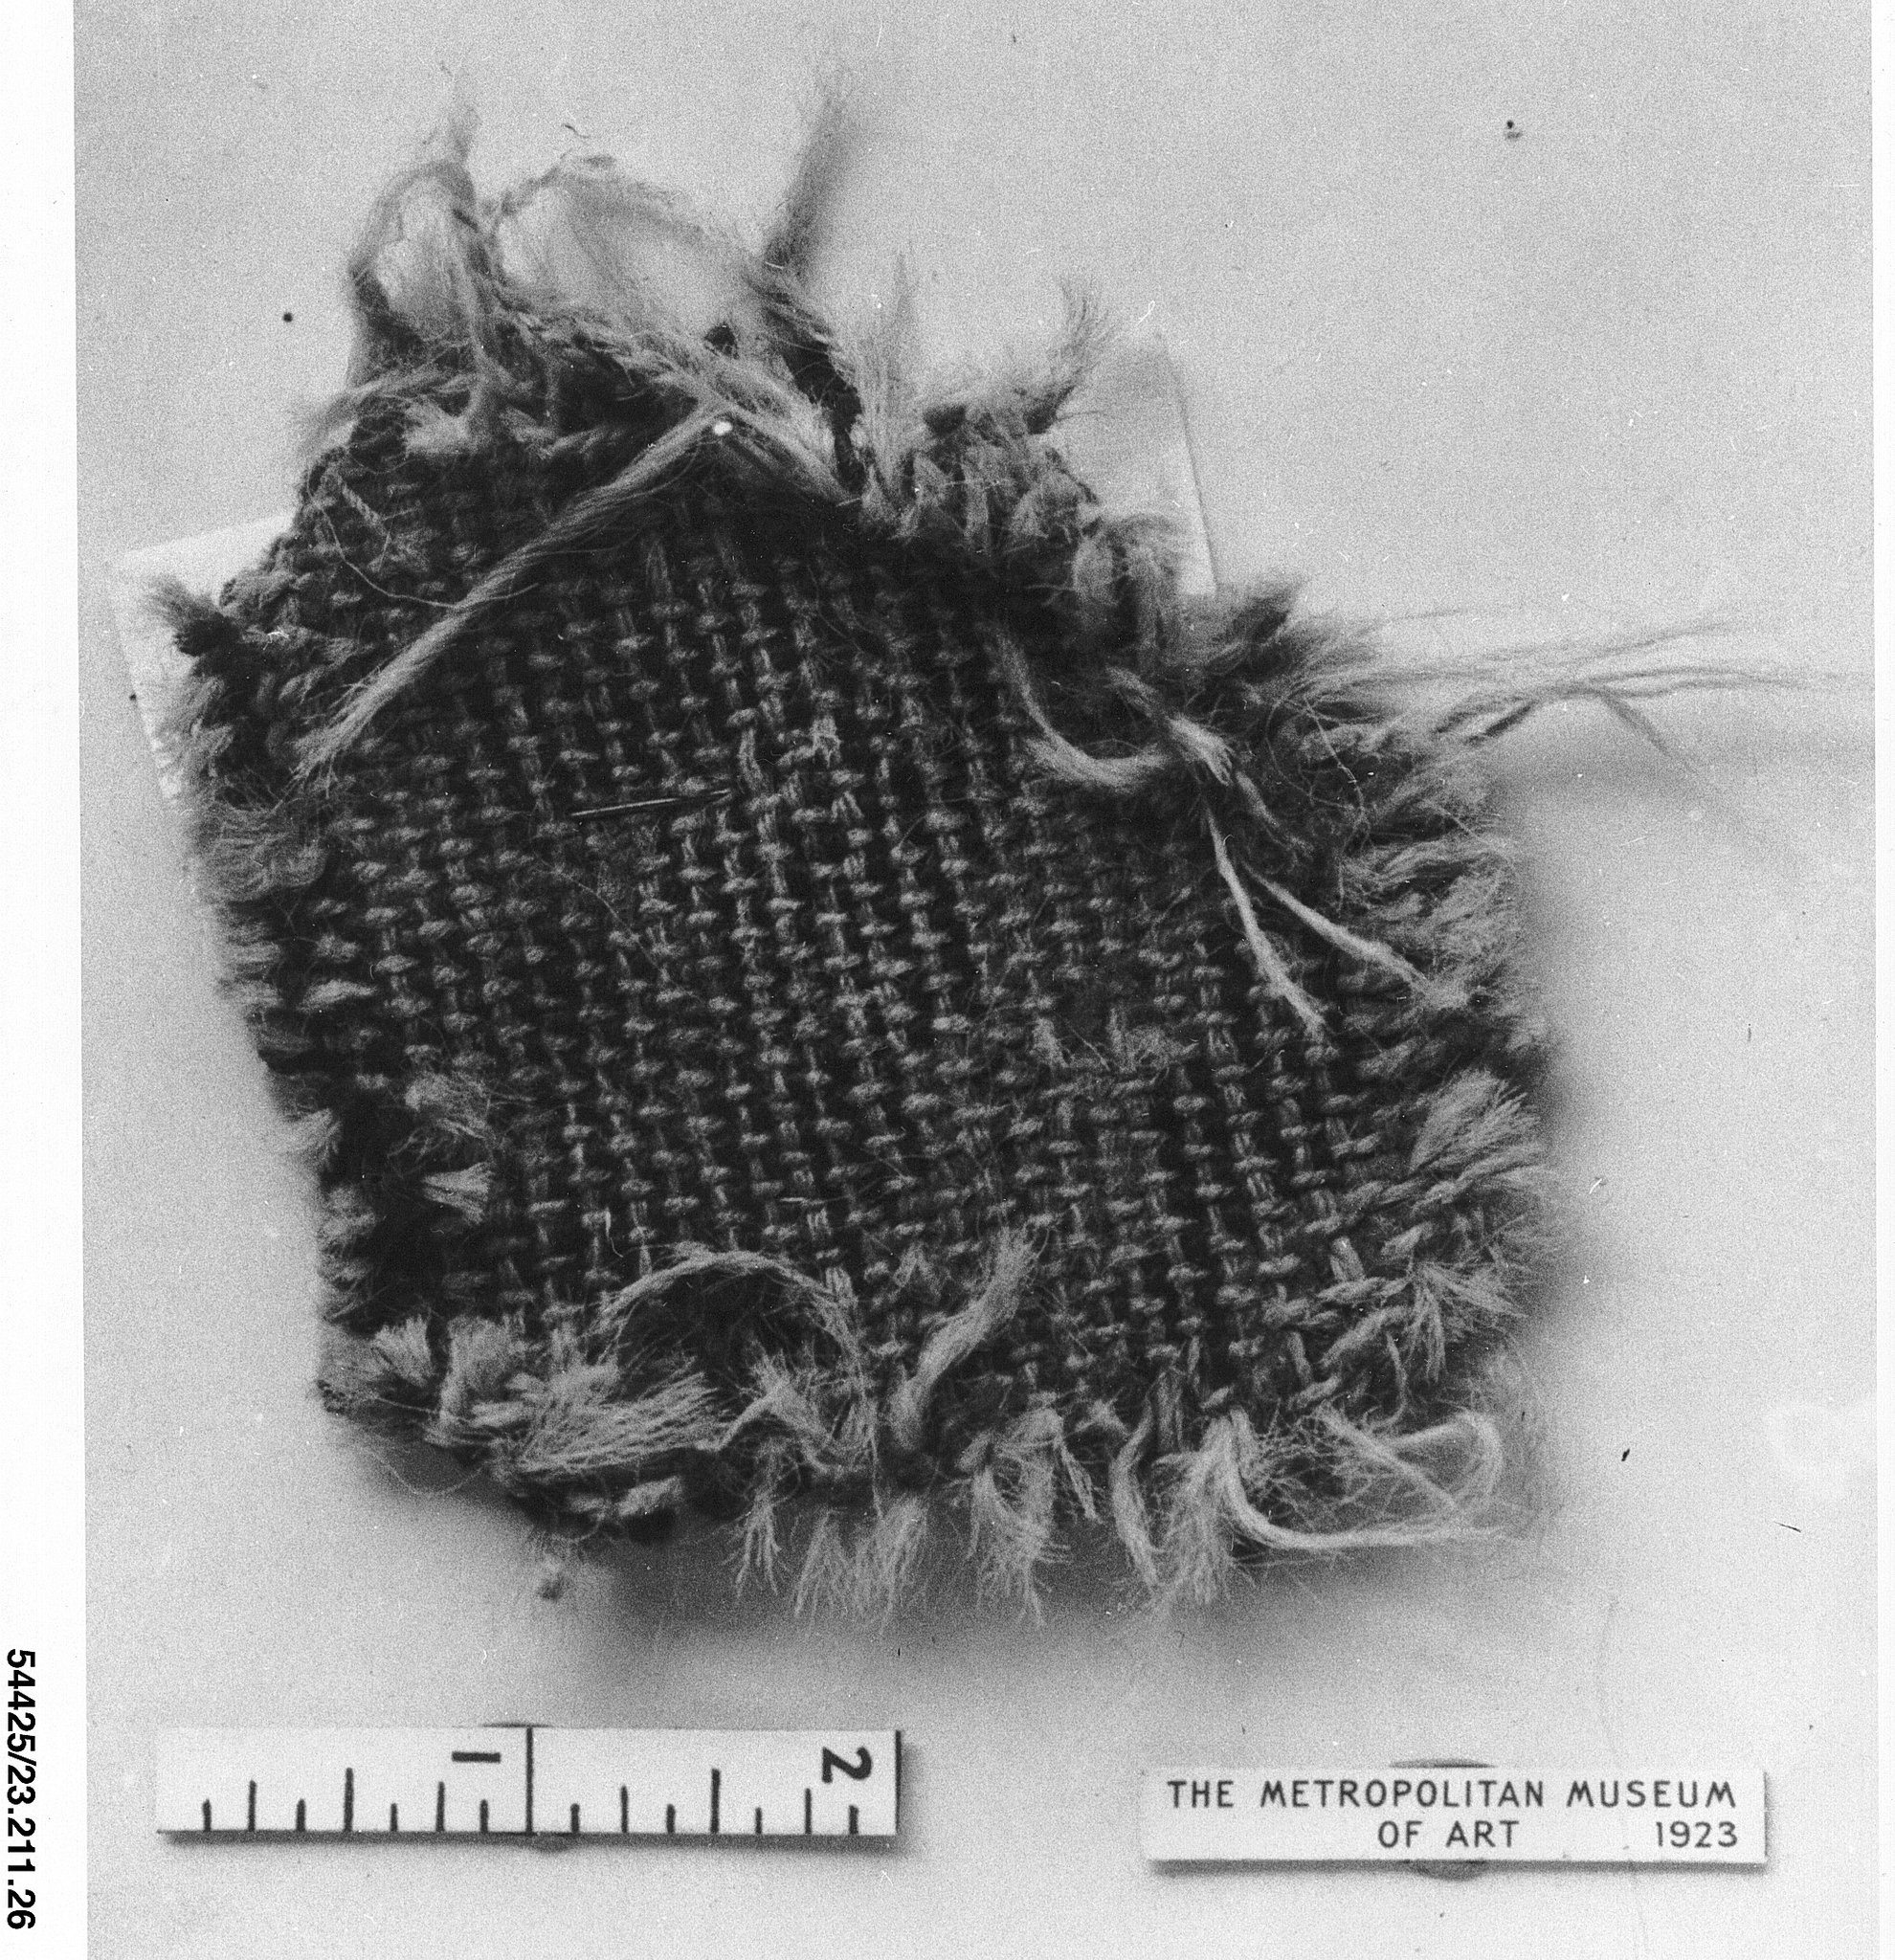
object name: rug fragment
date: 1501-1600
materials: wool